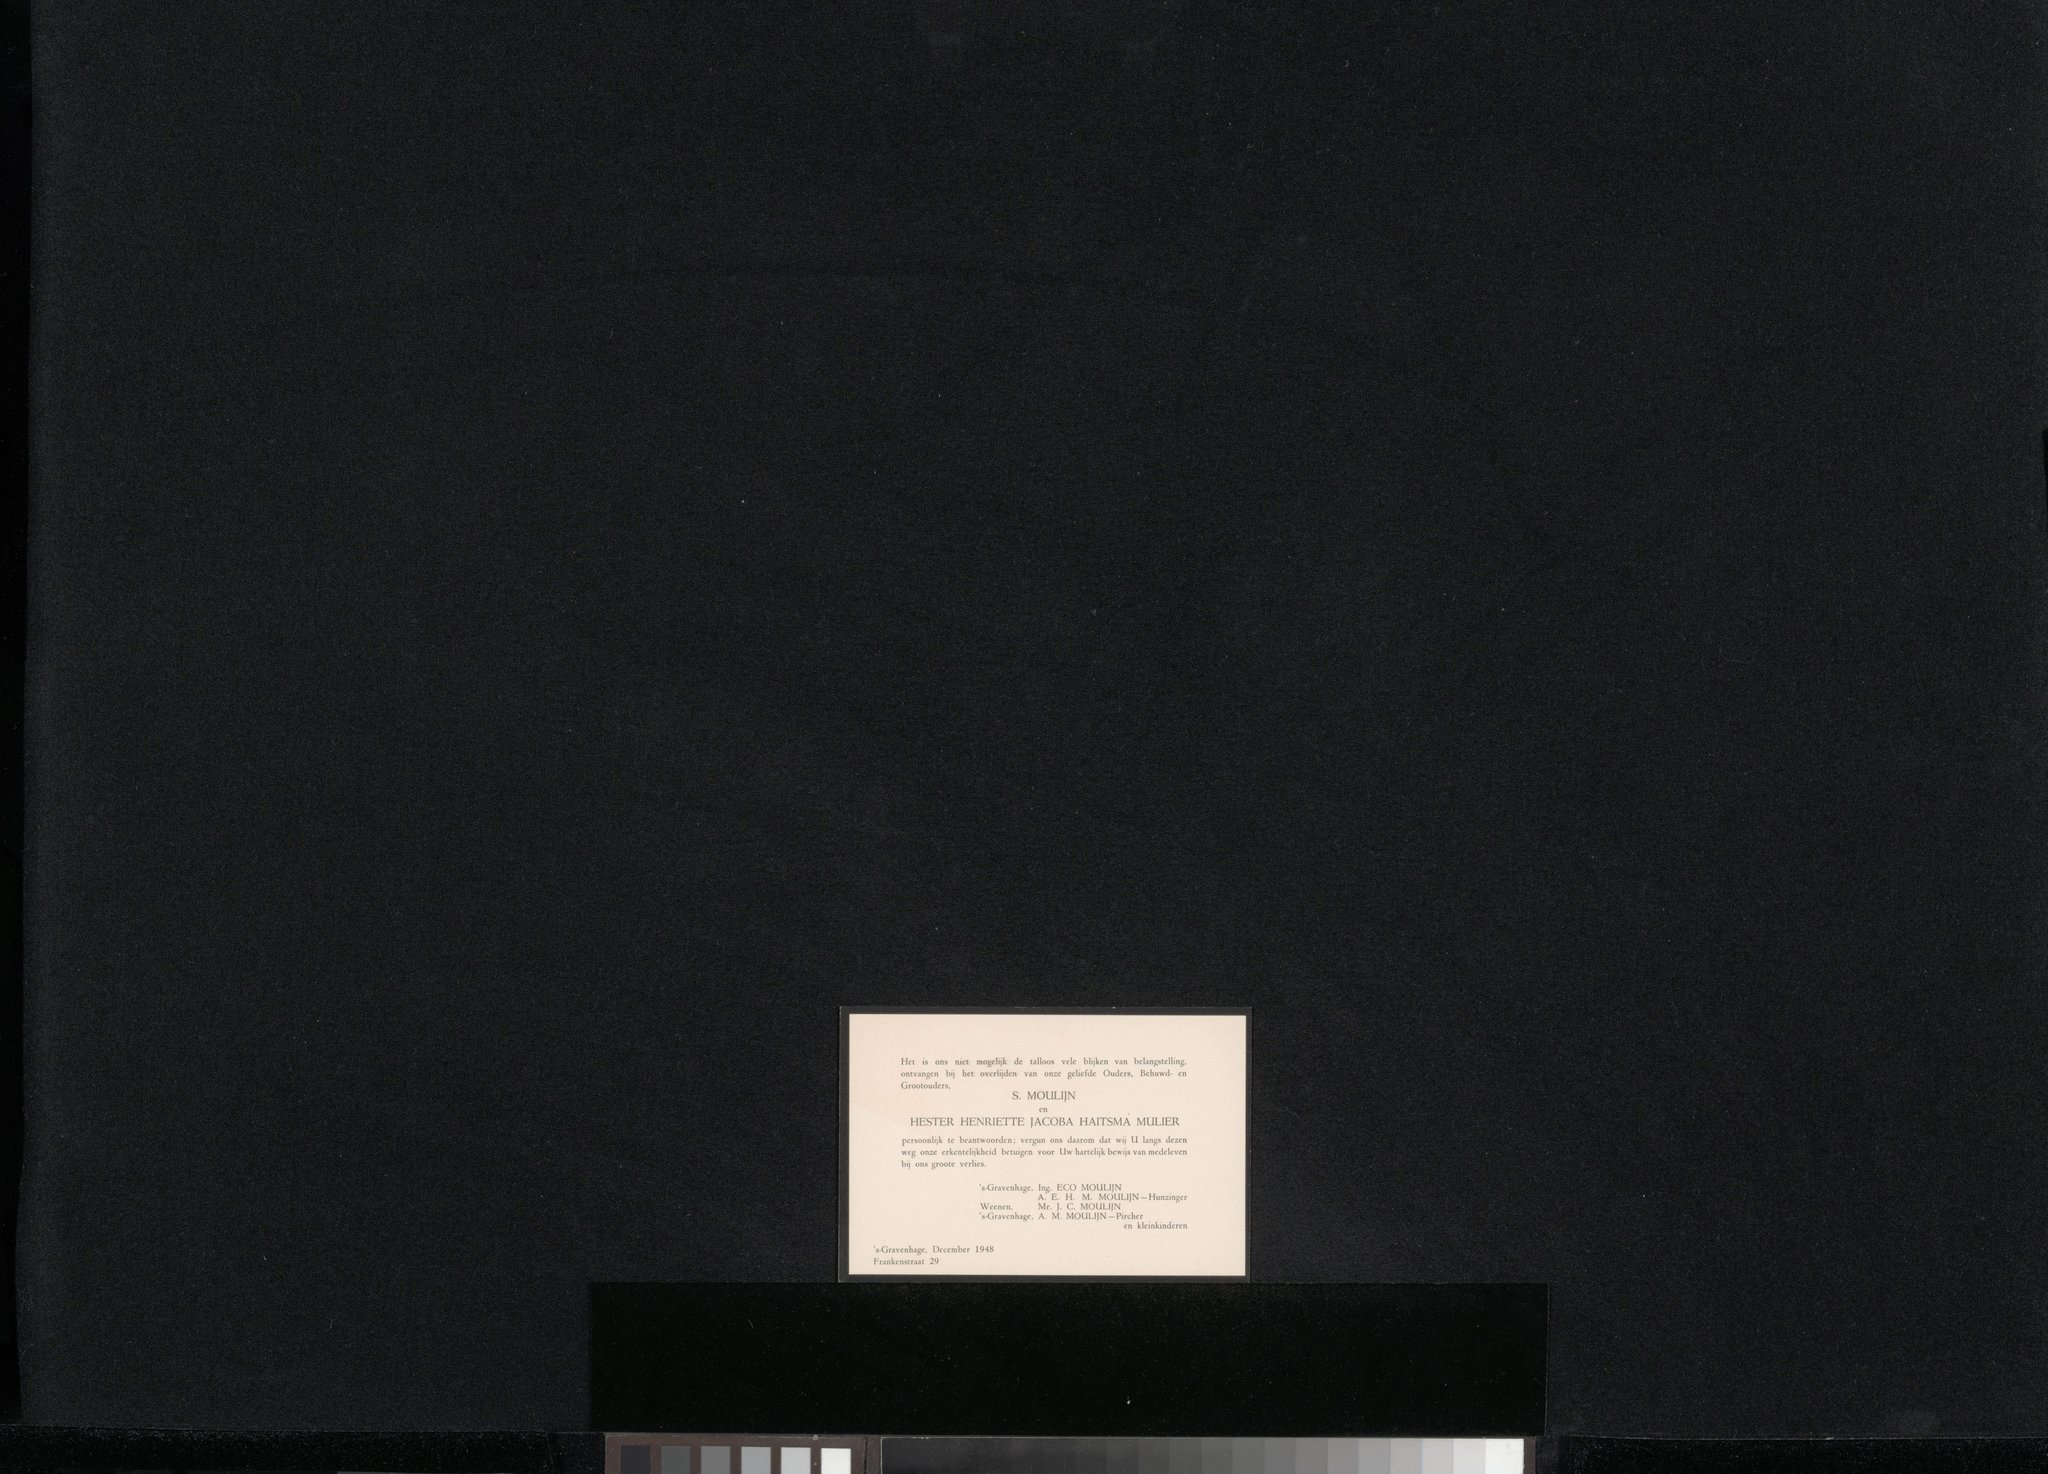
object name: bedankkaart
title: Bedankkaart aan de directie van het Rijksmuseum Amsterdam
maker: Anonymous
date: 1912-1948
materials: cardboard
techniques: printing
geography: the hague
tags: rotterdam, draughtsman, simon moulijn, rijksmuseum amsterdam